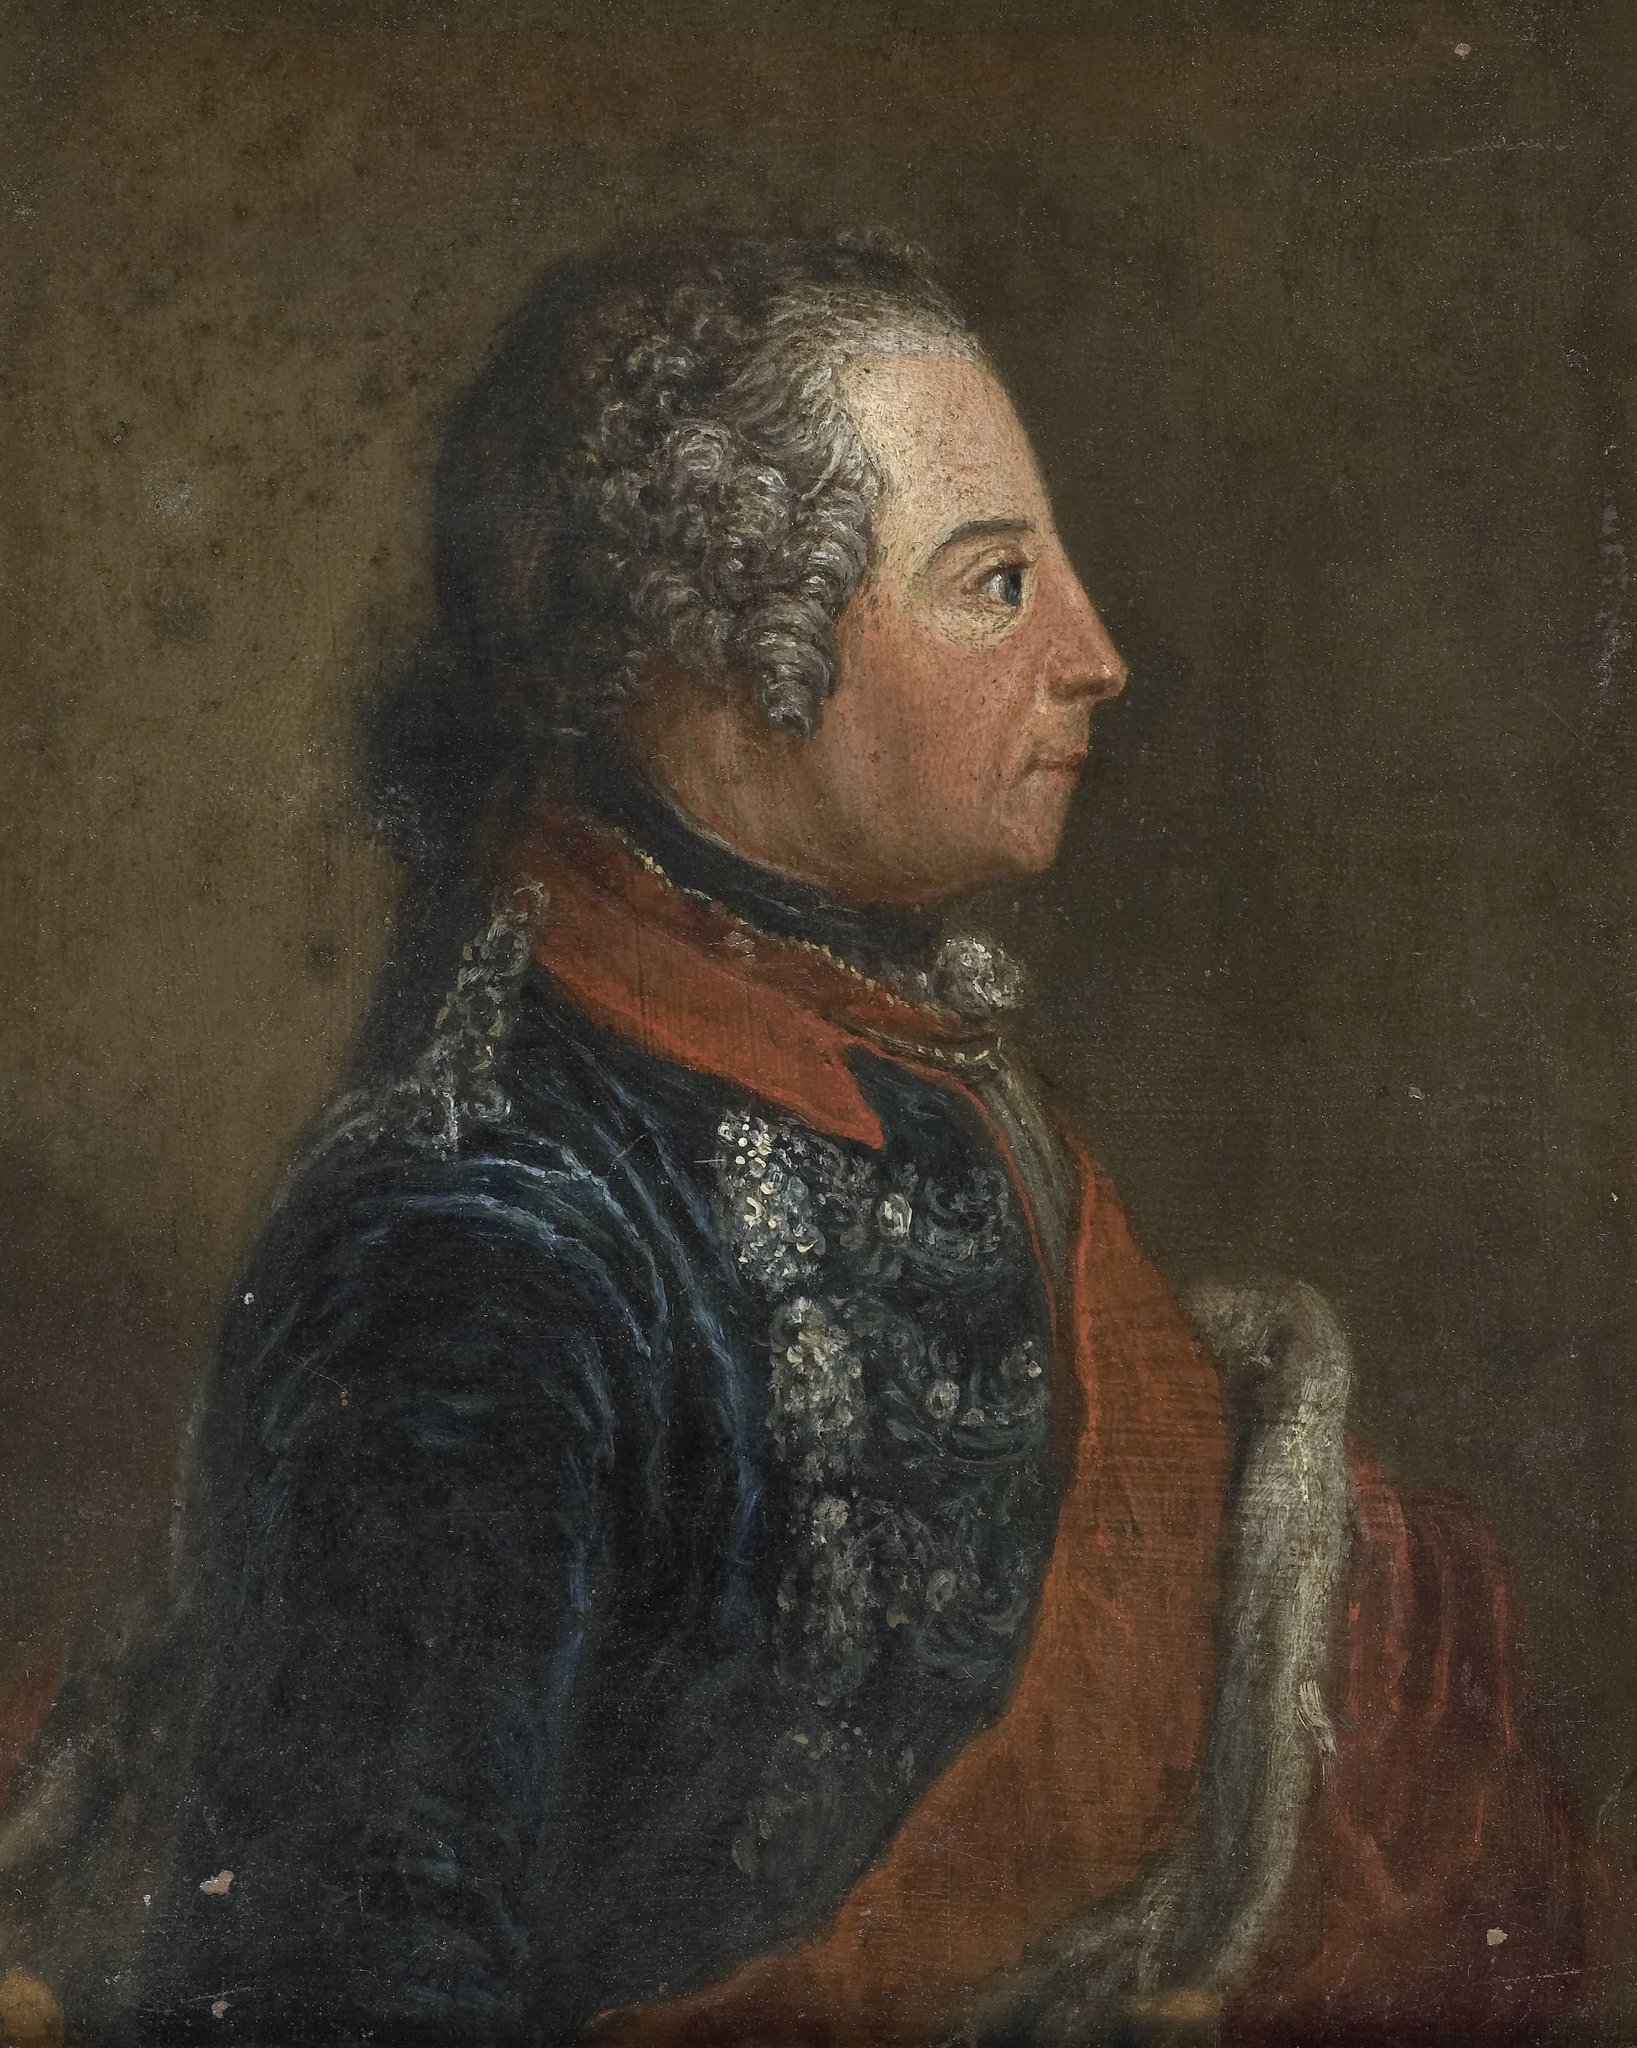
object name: painting, miniature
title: Frederik II de Grote (1712-86), koning van Pruisen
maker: Anonymous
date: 1750-1770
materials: copper, oil, wood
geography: germany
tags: berlin, frederick ii (king of prussia)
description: Portret van Frederik II de Grote (1712-86), koning van Pruisen. Ten halven lijve, in profiel naar rechts, in uniform. Onderdeel van de collectie portretminiaturen.